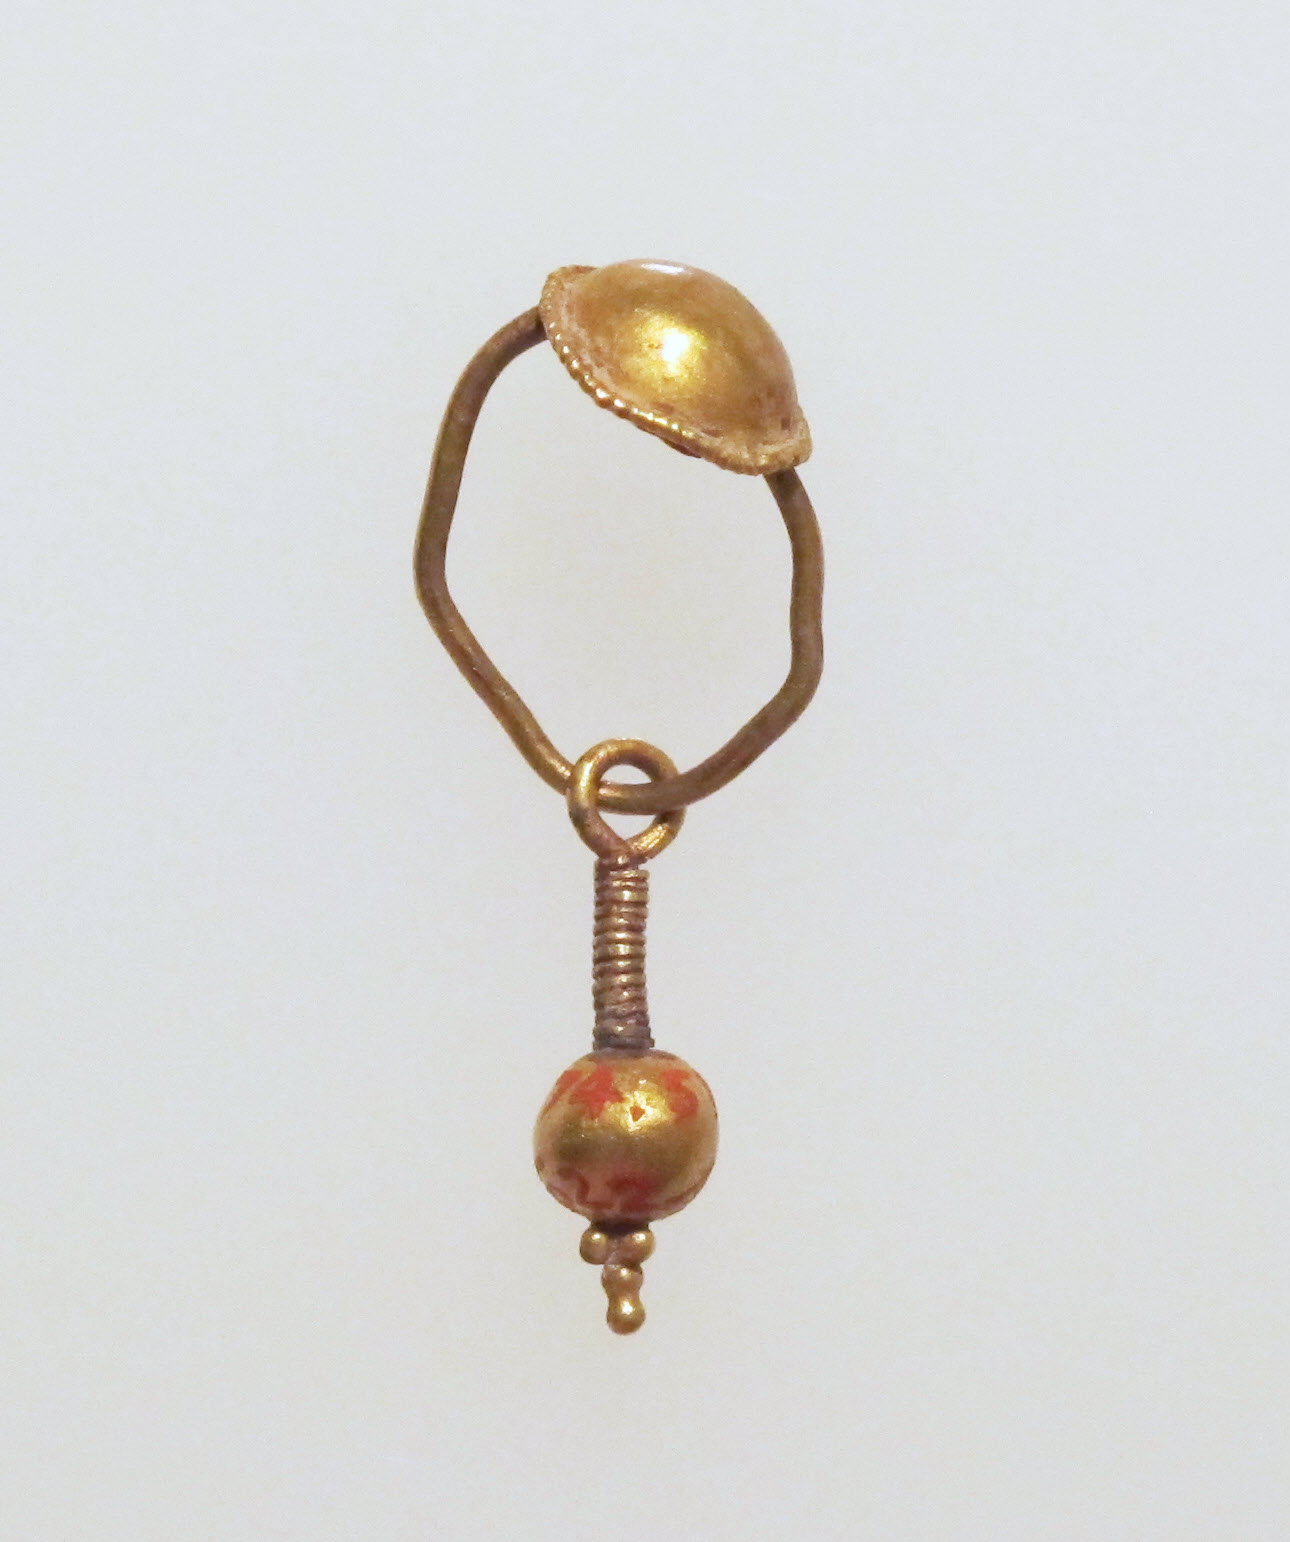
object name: earring with pendant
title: Gold earring with disc and pendant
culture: roman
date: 101-200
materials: gold